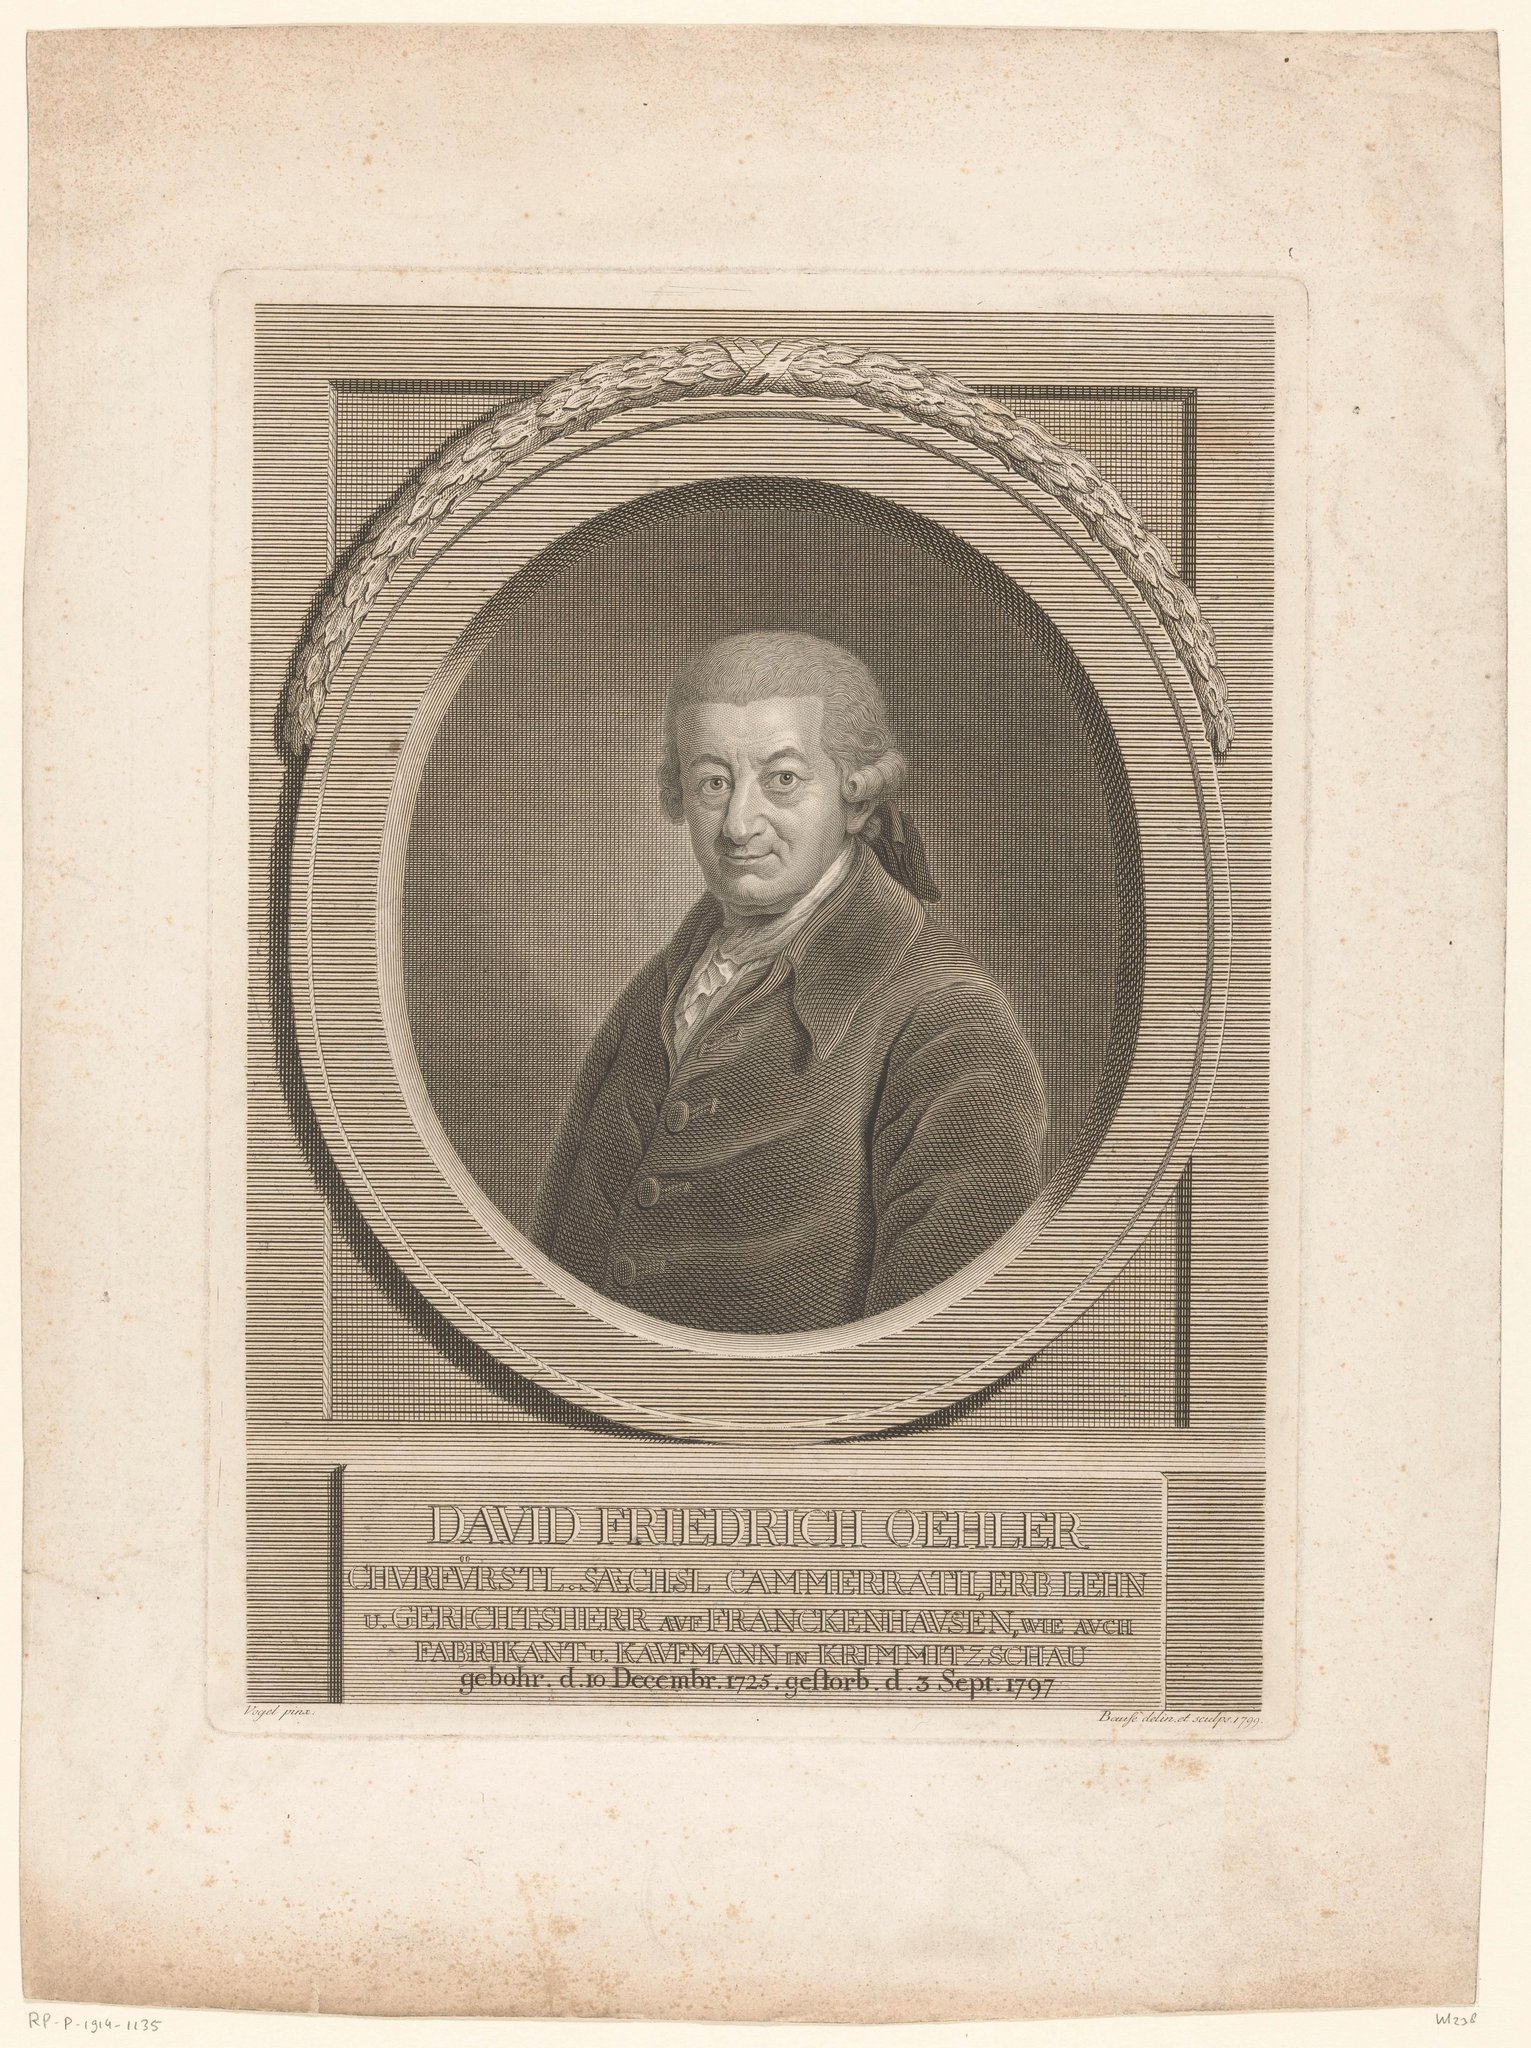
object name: print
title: Portret van David Friedrich Oehler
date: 1799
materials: paper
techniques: engraving, etching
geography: leipzig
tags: manufacturer, historical persons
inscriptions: collector's mark: Lugt 2228